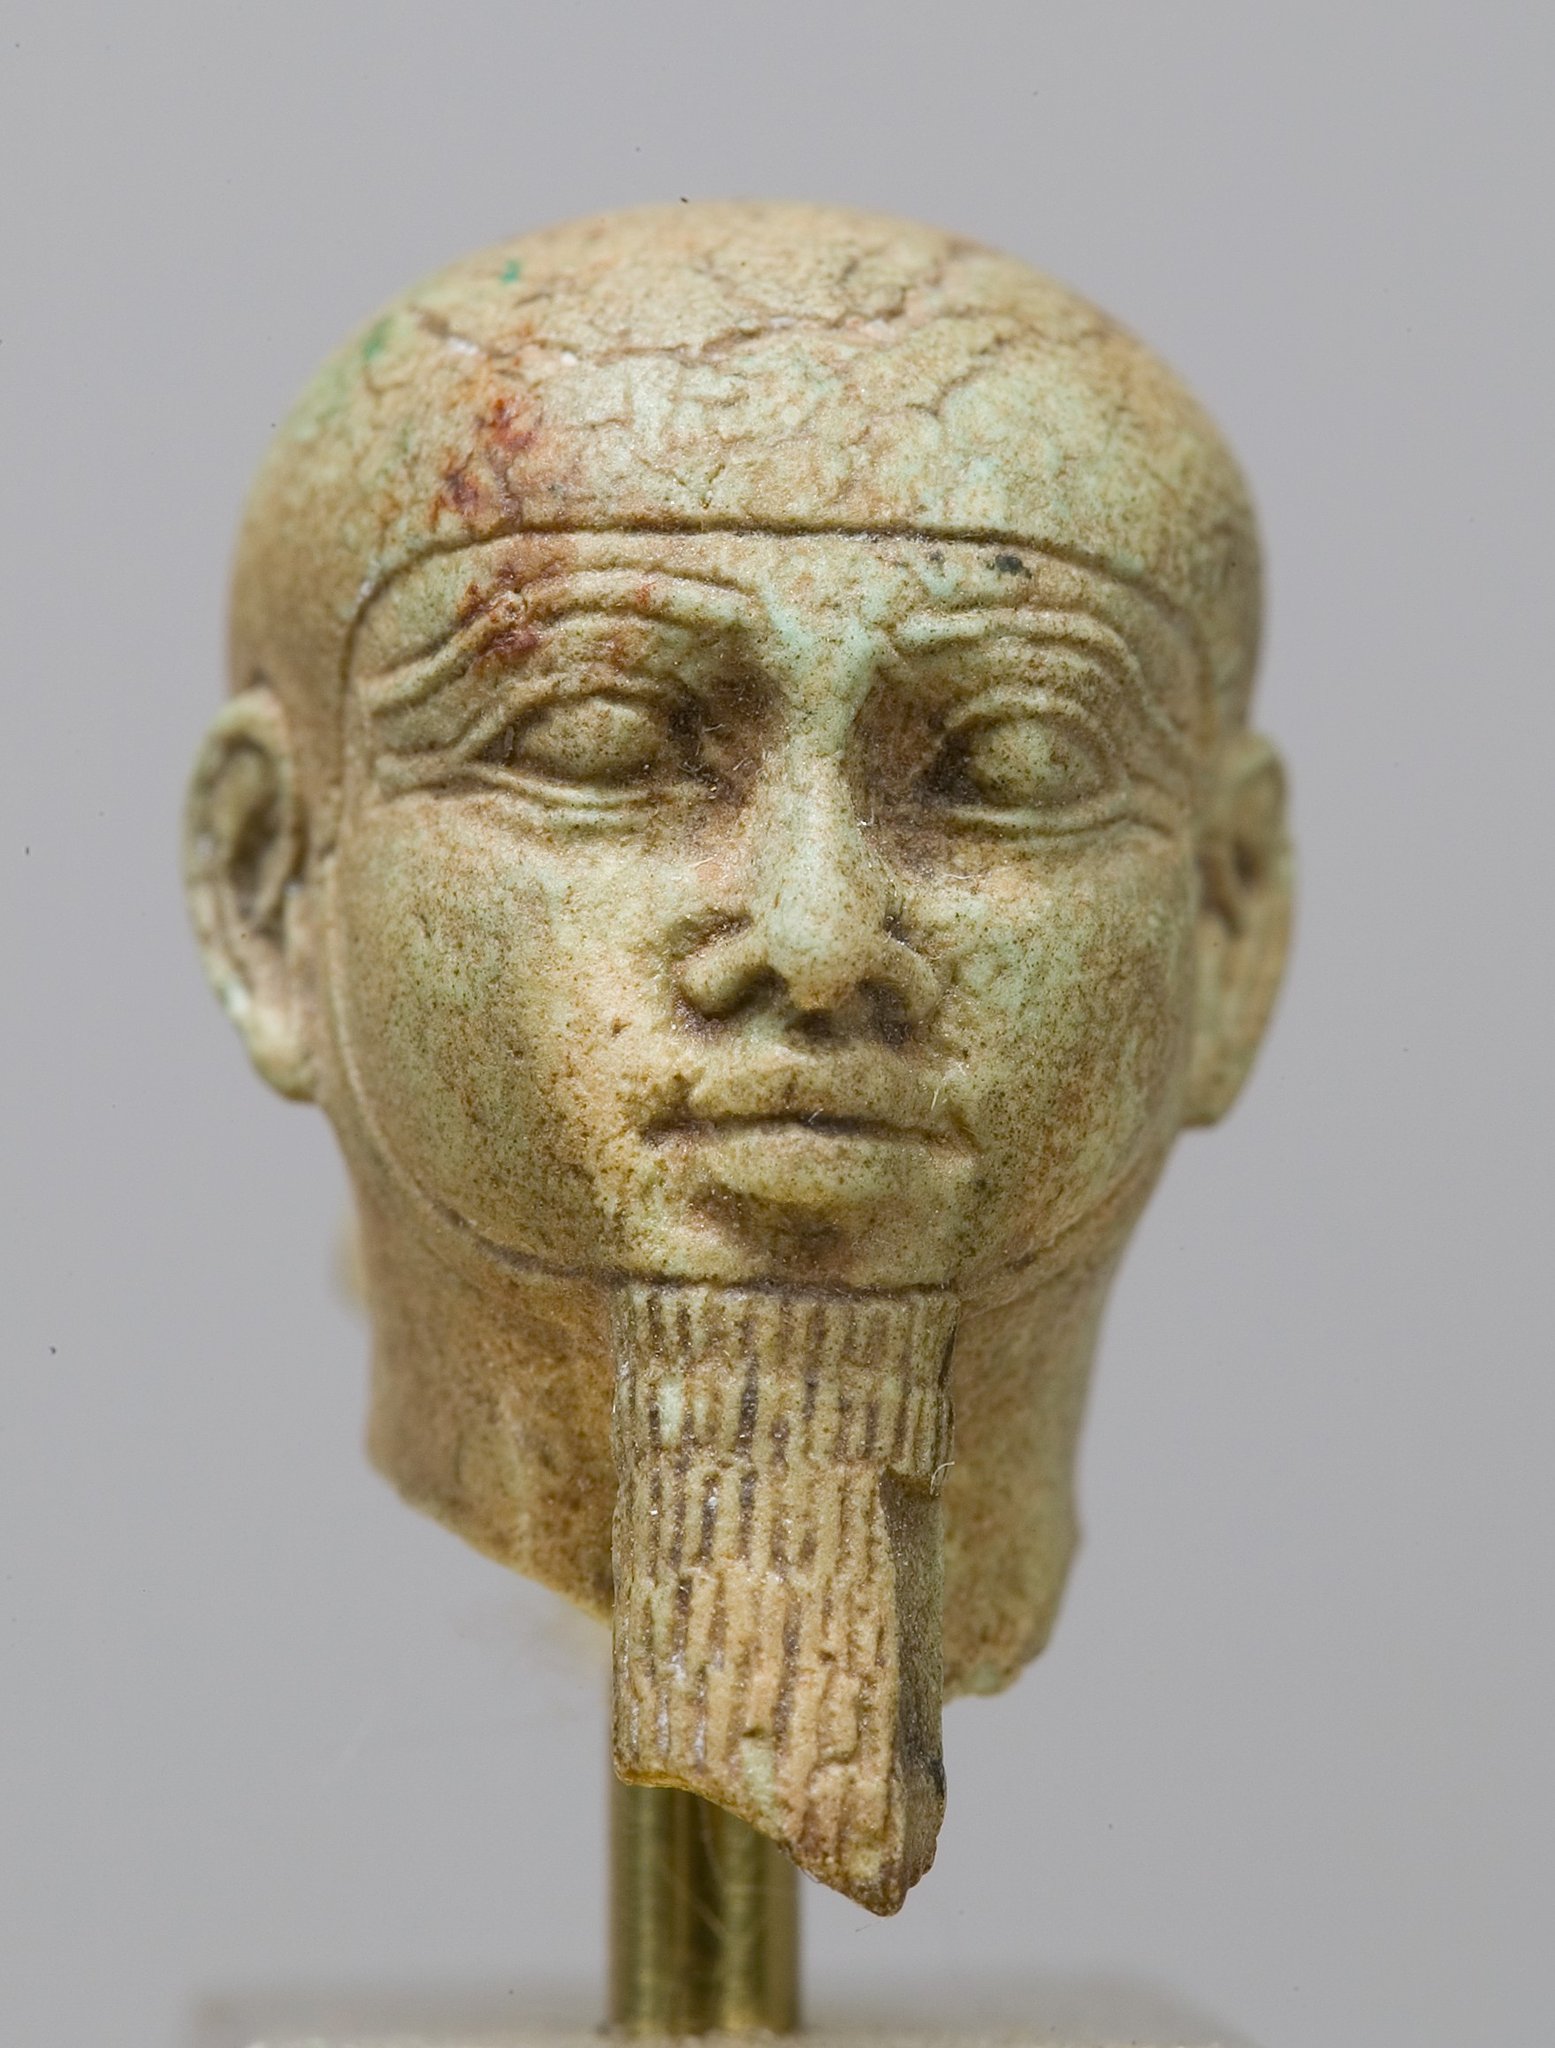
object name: head, ptah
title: Ptah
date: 734-635 BCE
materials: limestone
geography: egypt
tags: heads